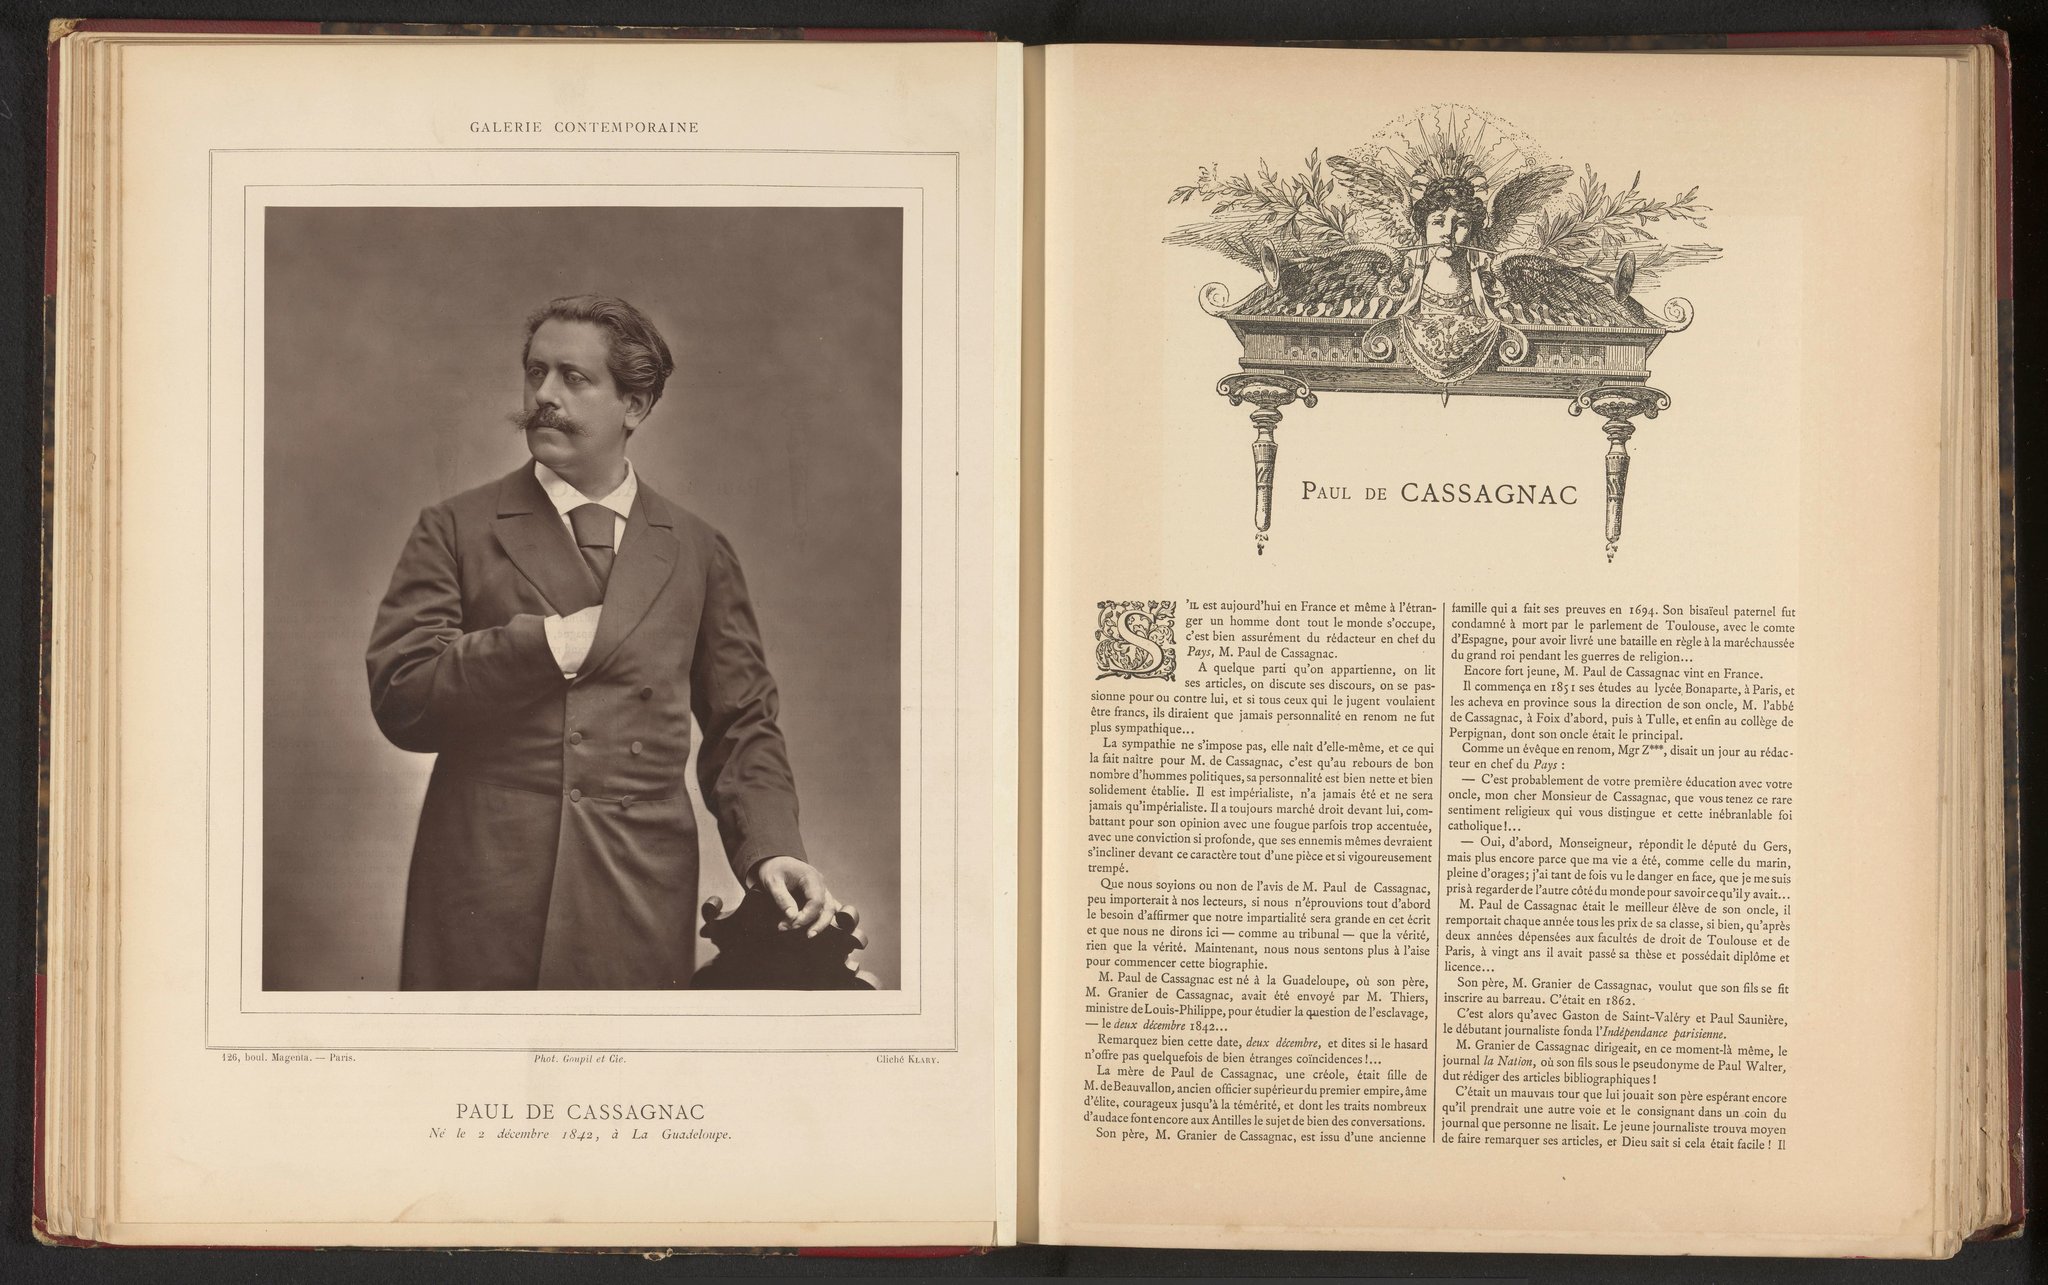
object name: page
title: Paul de Cassagnac. Ne le 2 decembre 1842, a La Guadeloupe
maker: charles louis klary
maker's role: fotograaf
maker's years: 1837-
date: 1876-1879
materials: paper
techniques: woodburytype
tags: politician, journalist, reporter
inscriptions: inscription: ‘126, boul. Magenta.-Paris.’